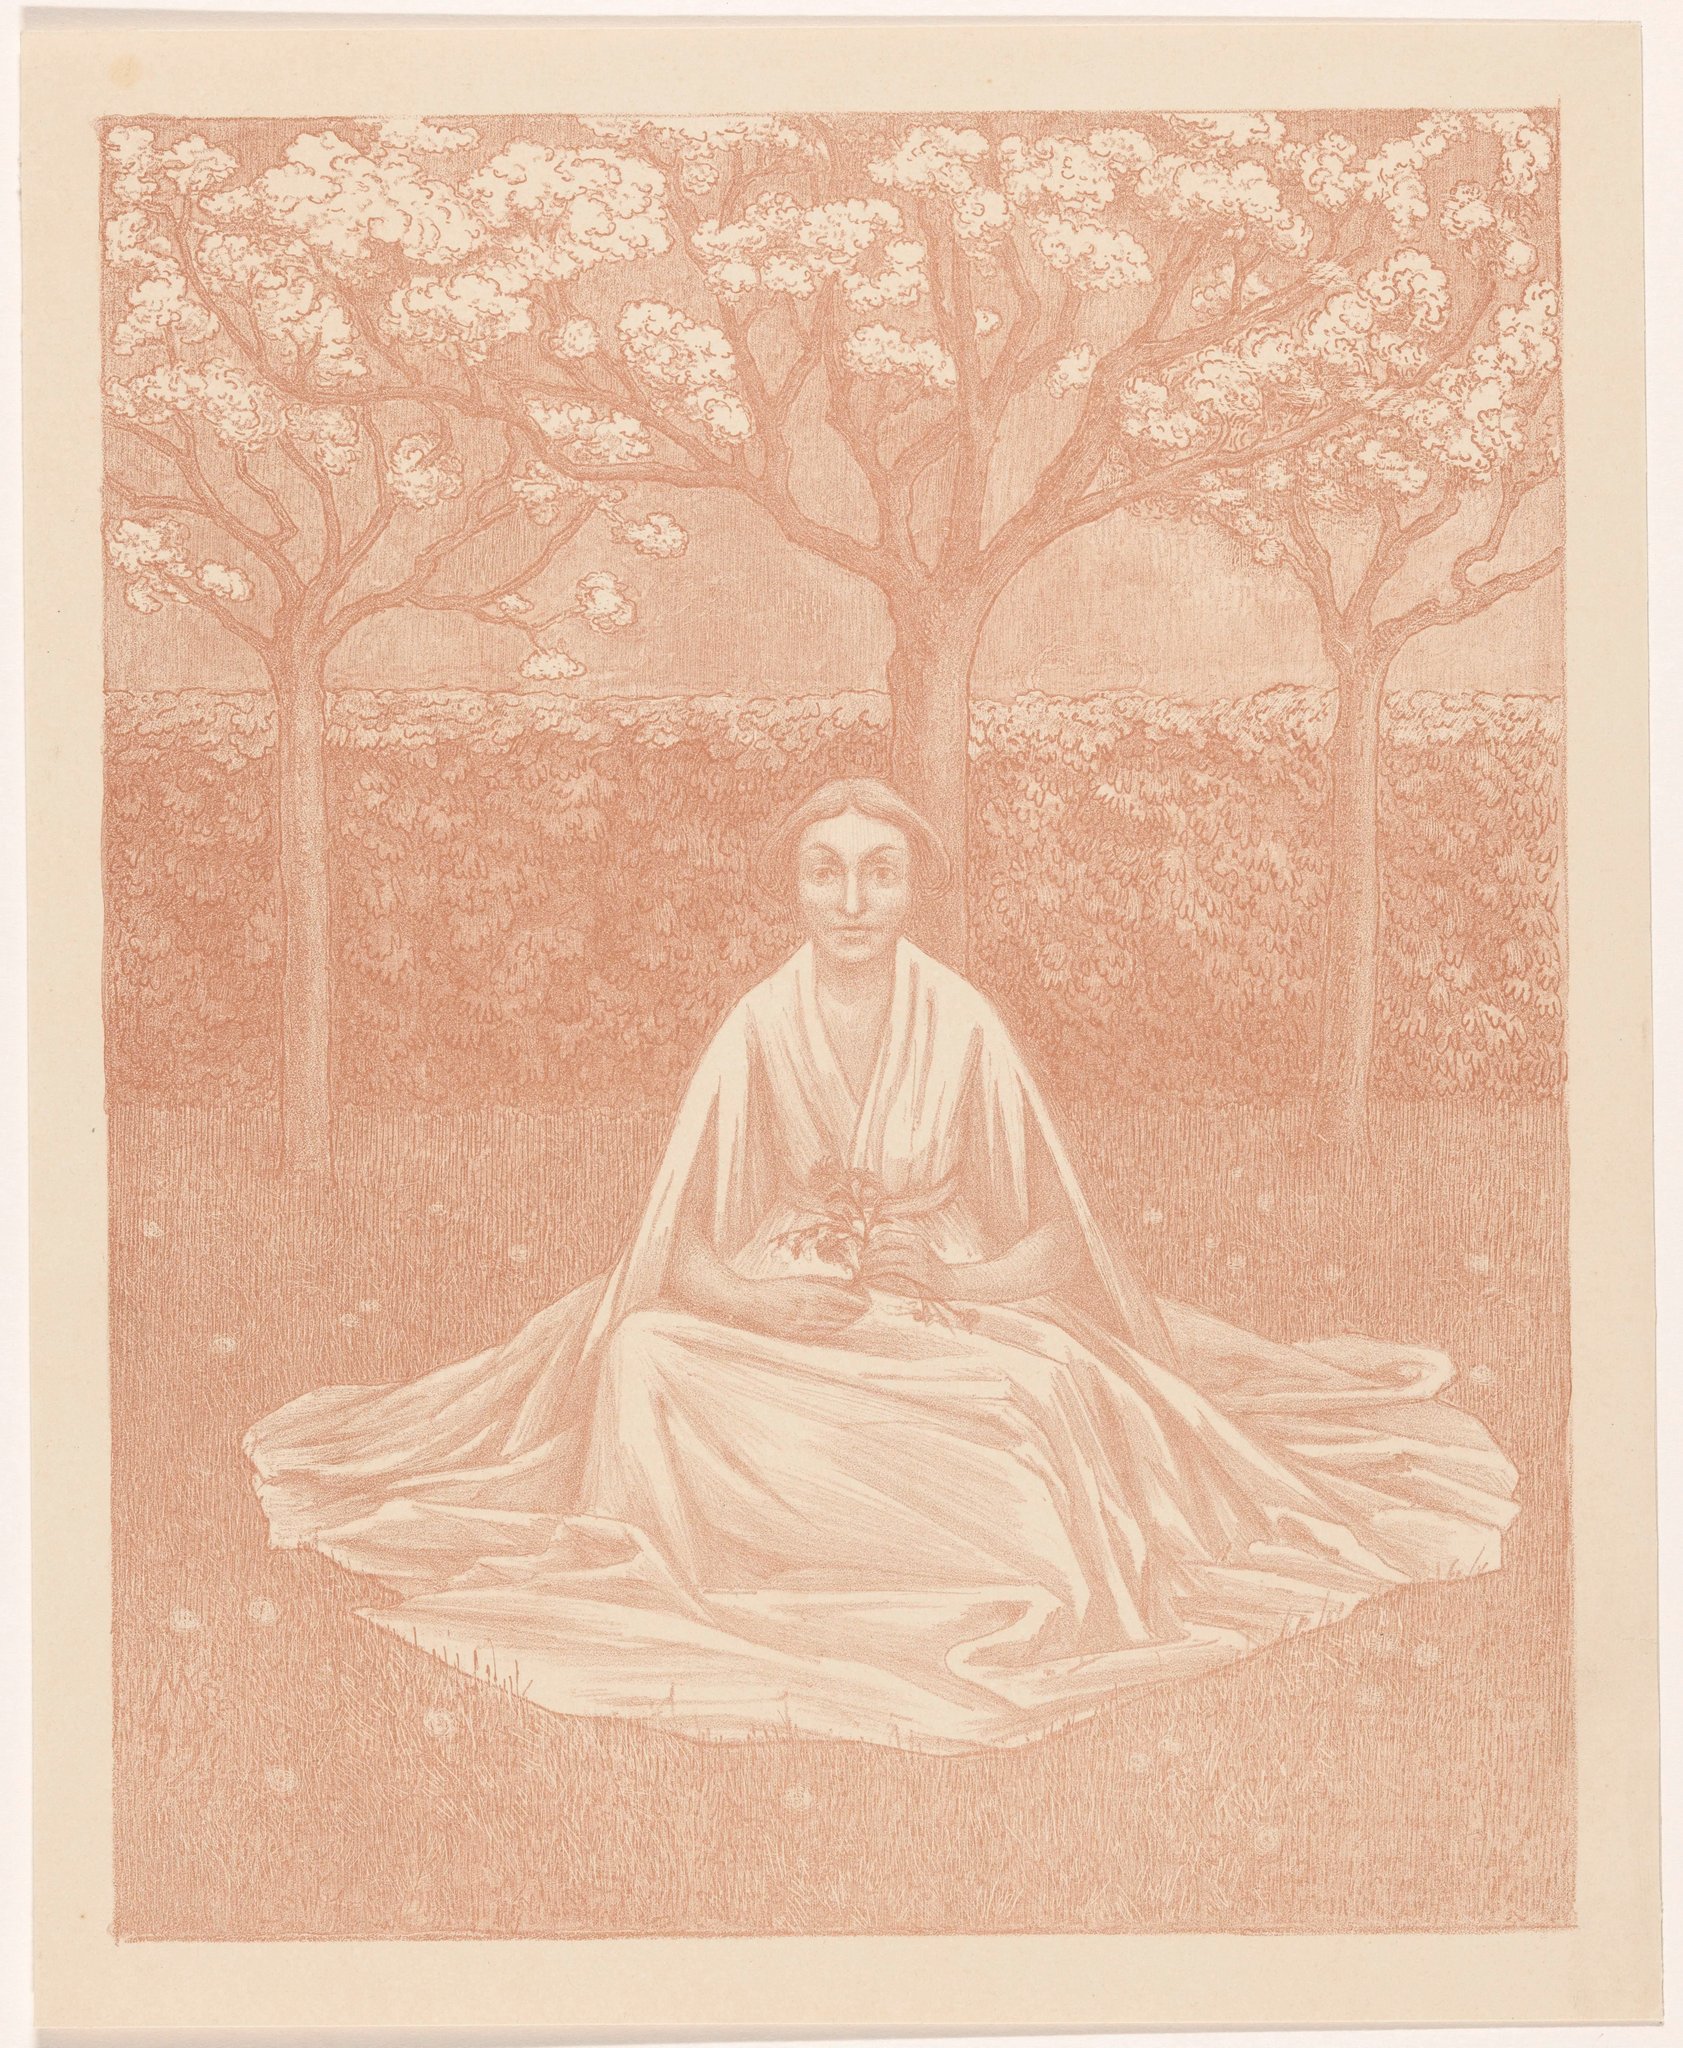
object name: print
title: Vrouw met jurk zittend in grasveld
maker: simon moulijn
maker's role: draughtsman, print maker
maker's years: 1866-1948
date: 1915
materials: paper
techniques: lithograph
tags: adult woman, sitting figure - aa - female human figure, dress, gown, trees (+ flowers, blossom, blossoming)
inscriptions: collector's mark: Lugt 2228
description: Een vrouw zit in een grasveld met de stof van haar jurk om zich heen gedrapeerd. In haar handen houdt ze een bloem. Achter haar staan drie bloeiende bomen voor een heg.